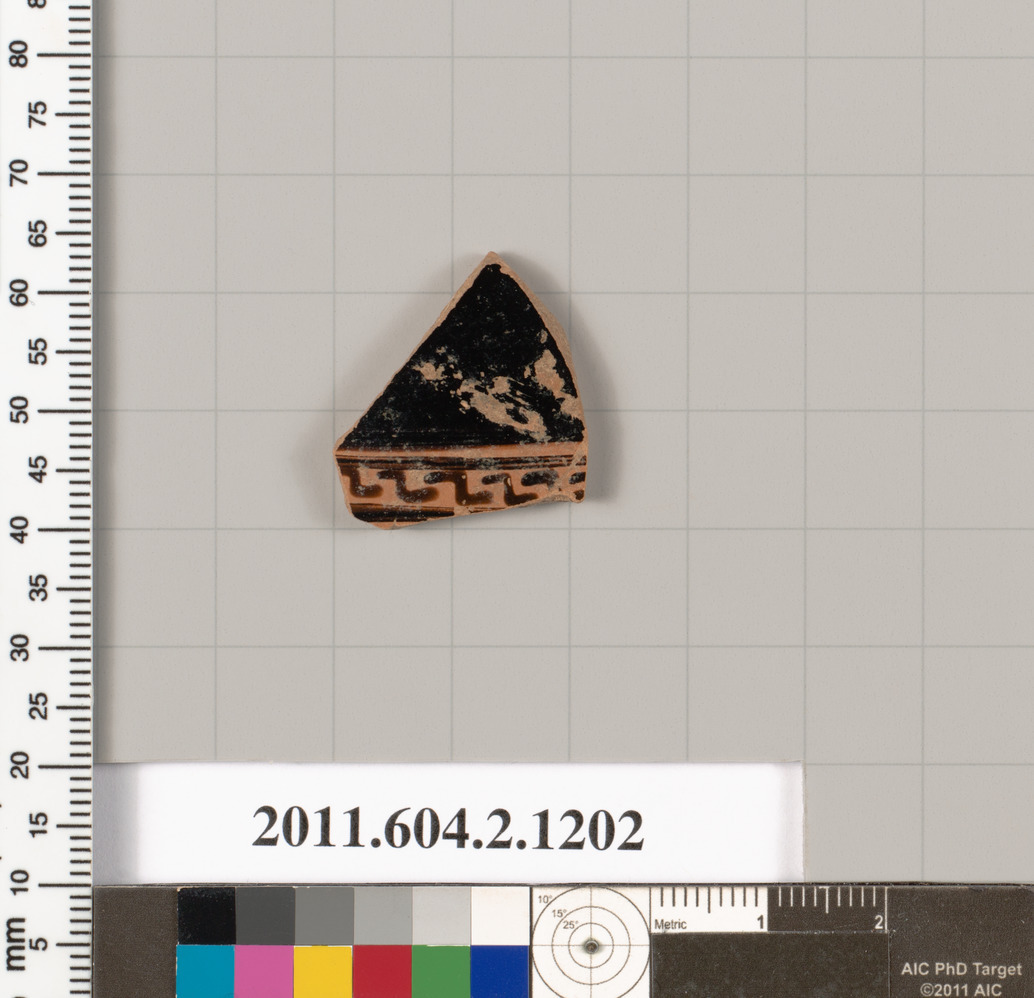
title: Terracotta fragment from an open shape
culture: greek, attic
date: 450-401 BCE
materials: terracotta